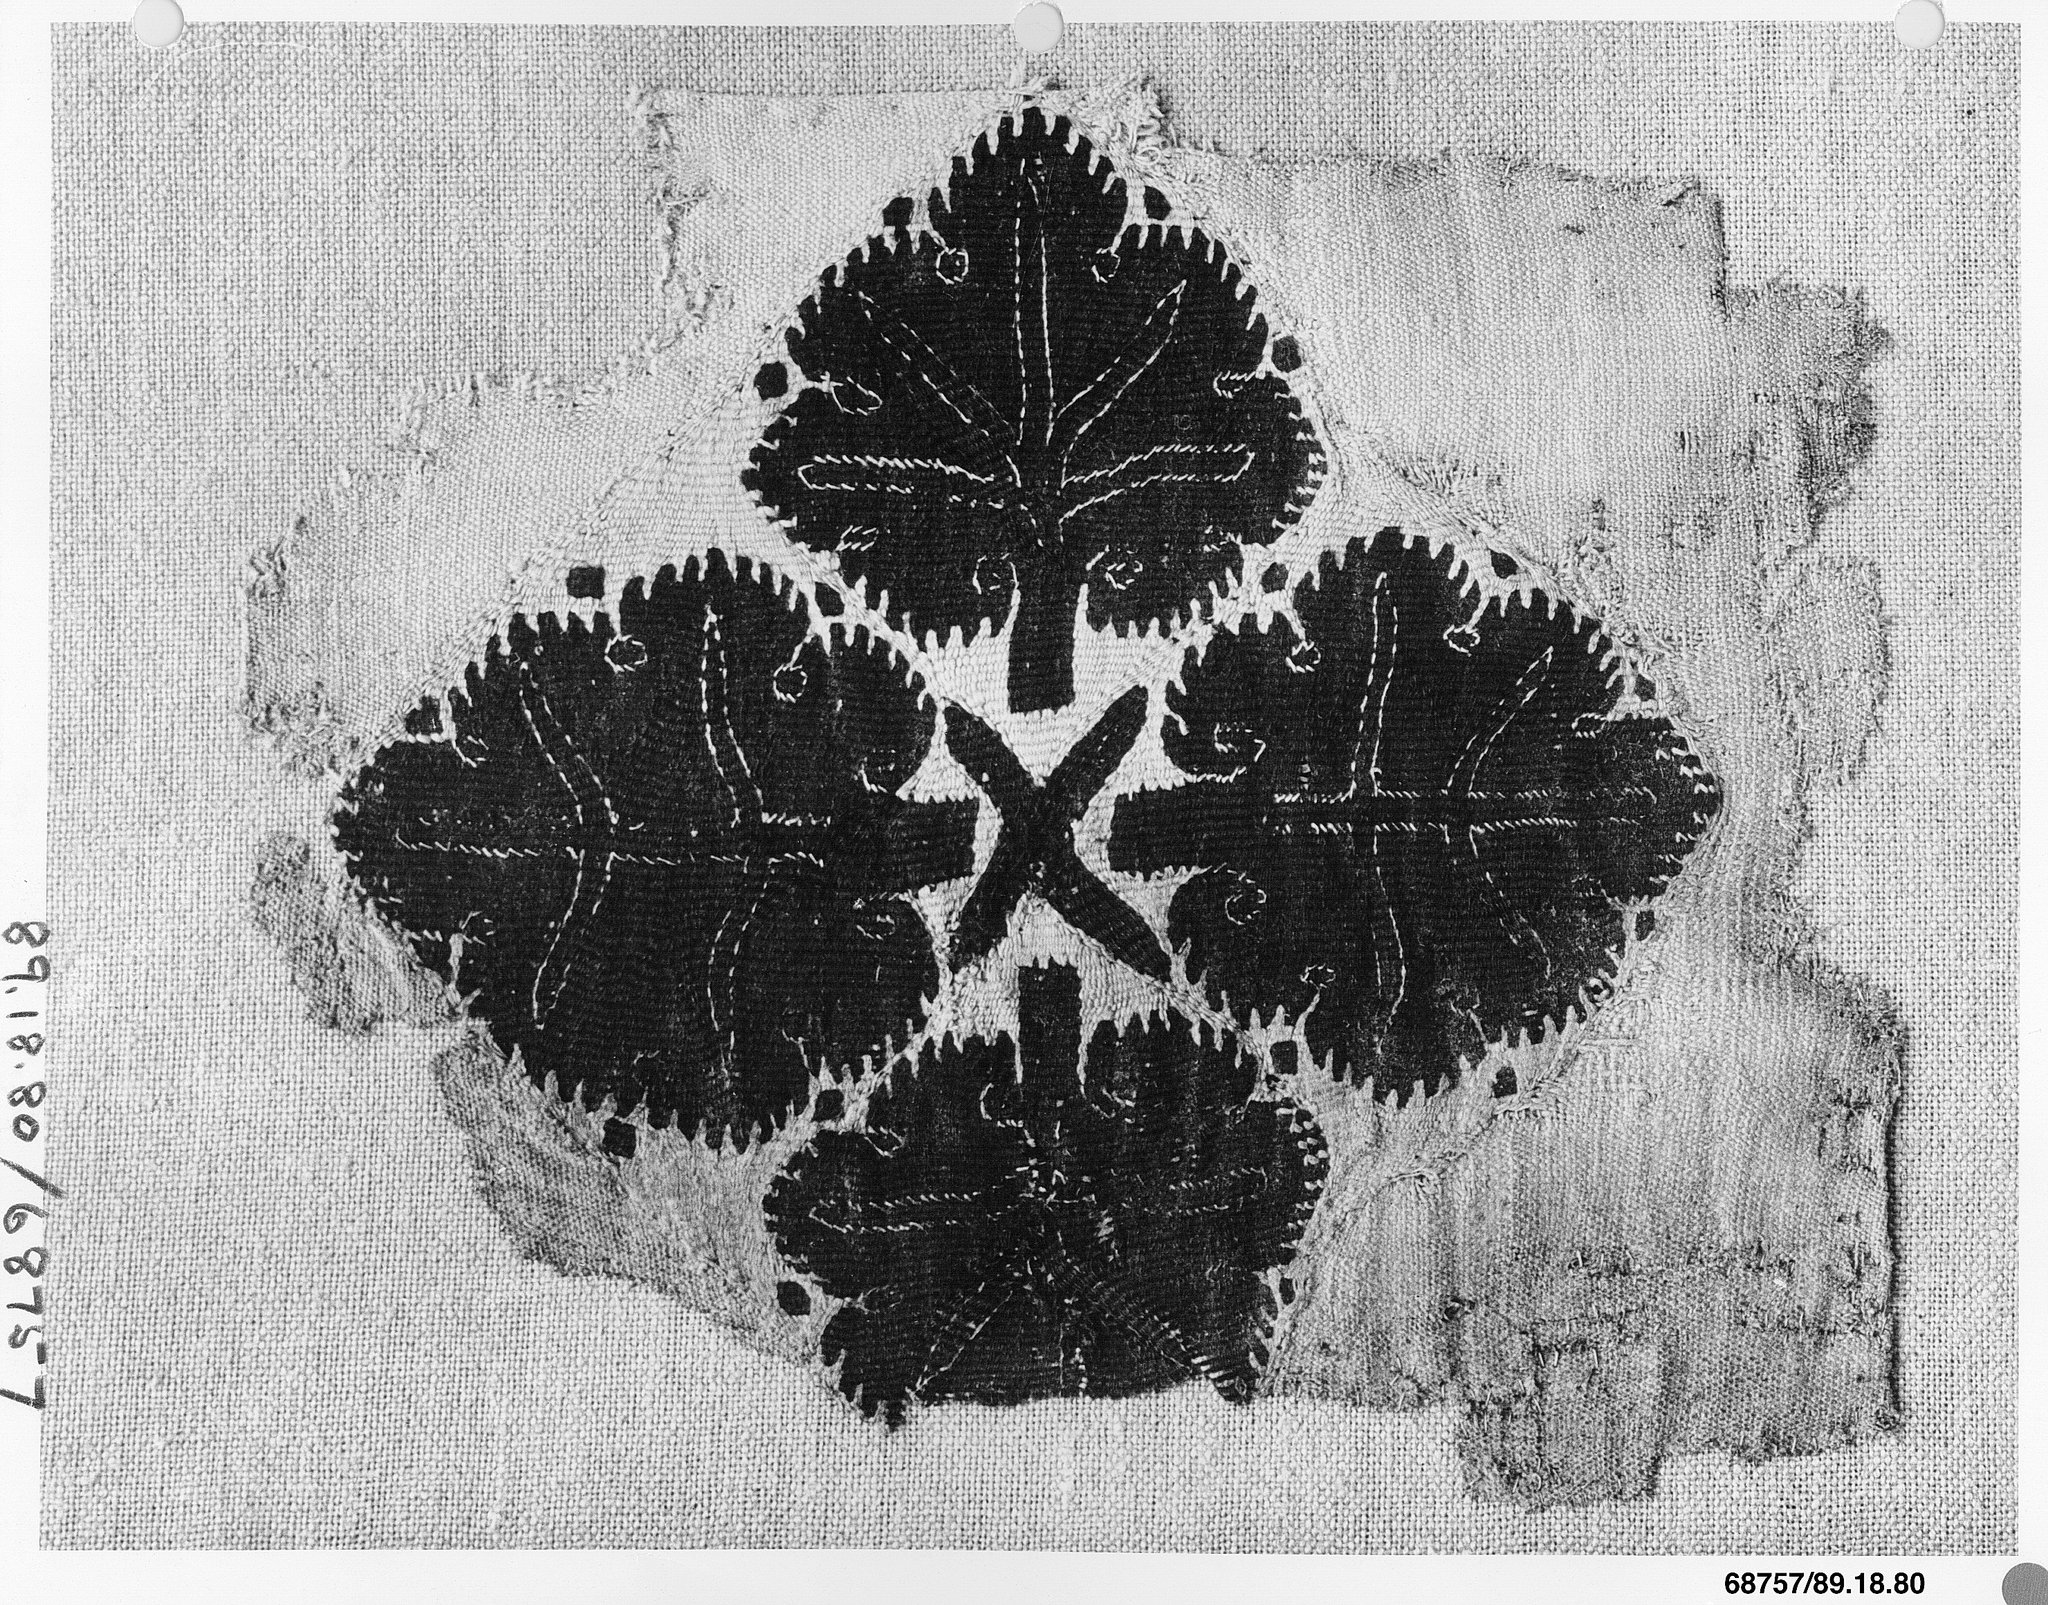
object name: textile fragment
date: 201-400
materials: linen, wool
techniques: weave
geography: egypt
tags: leaves